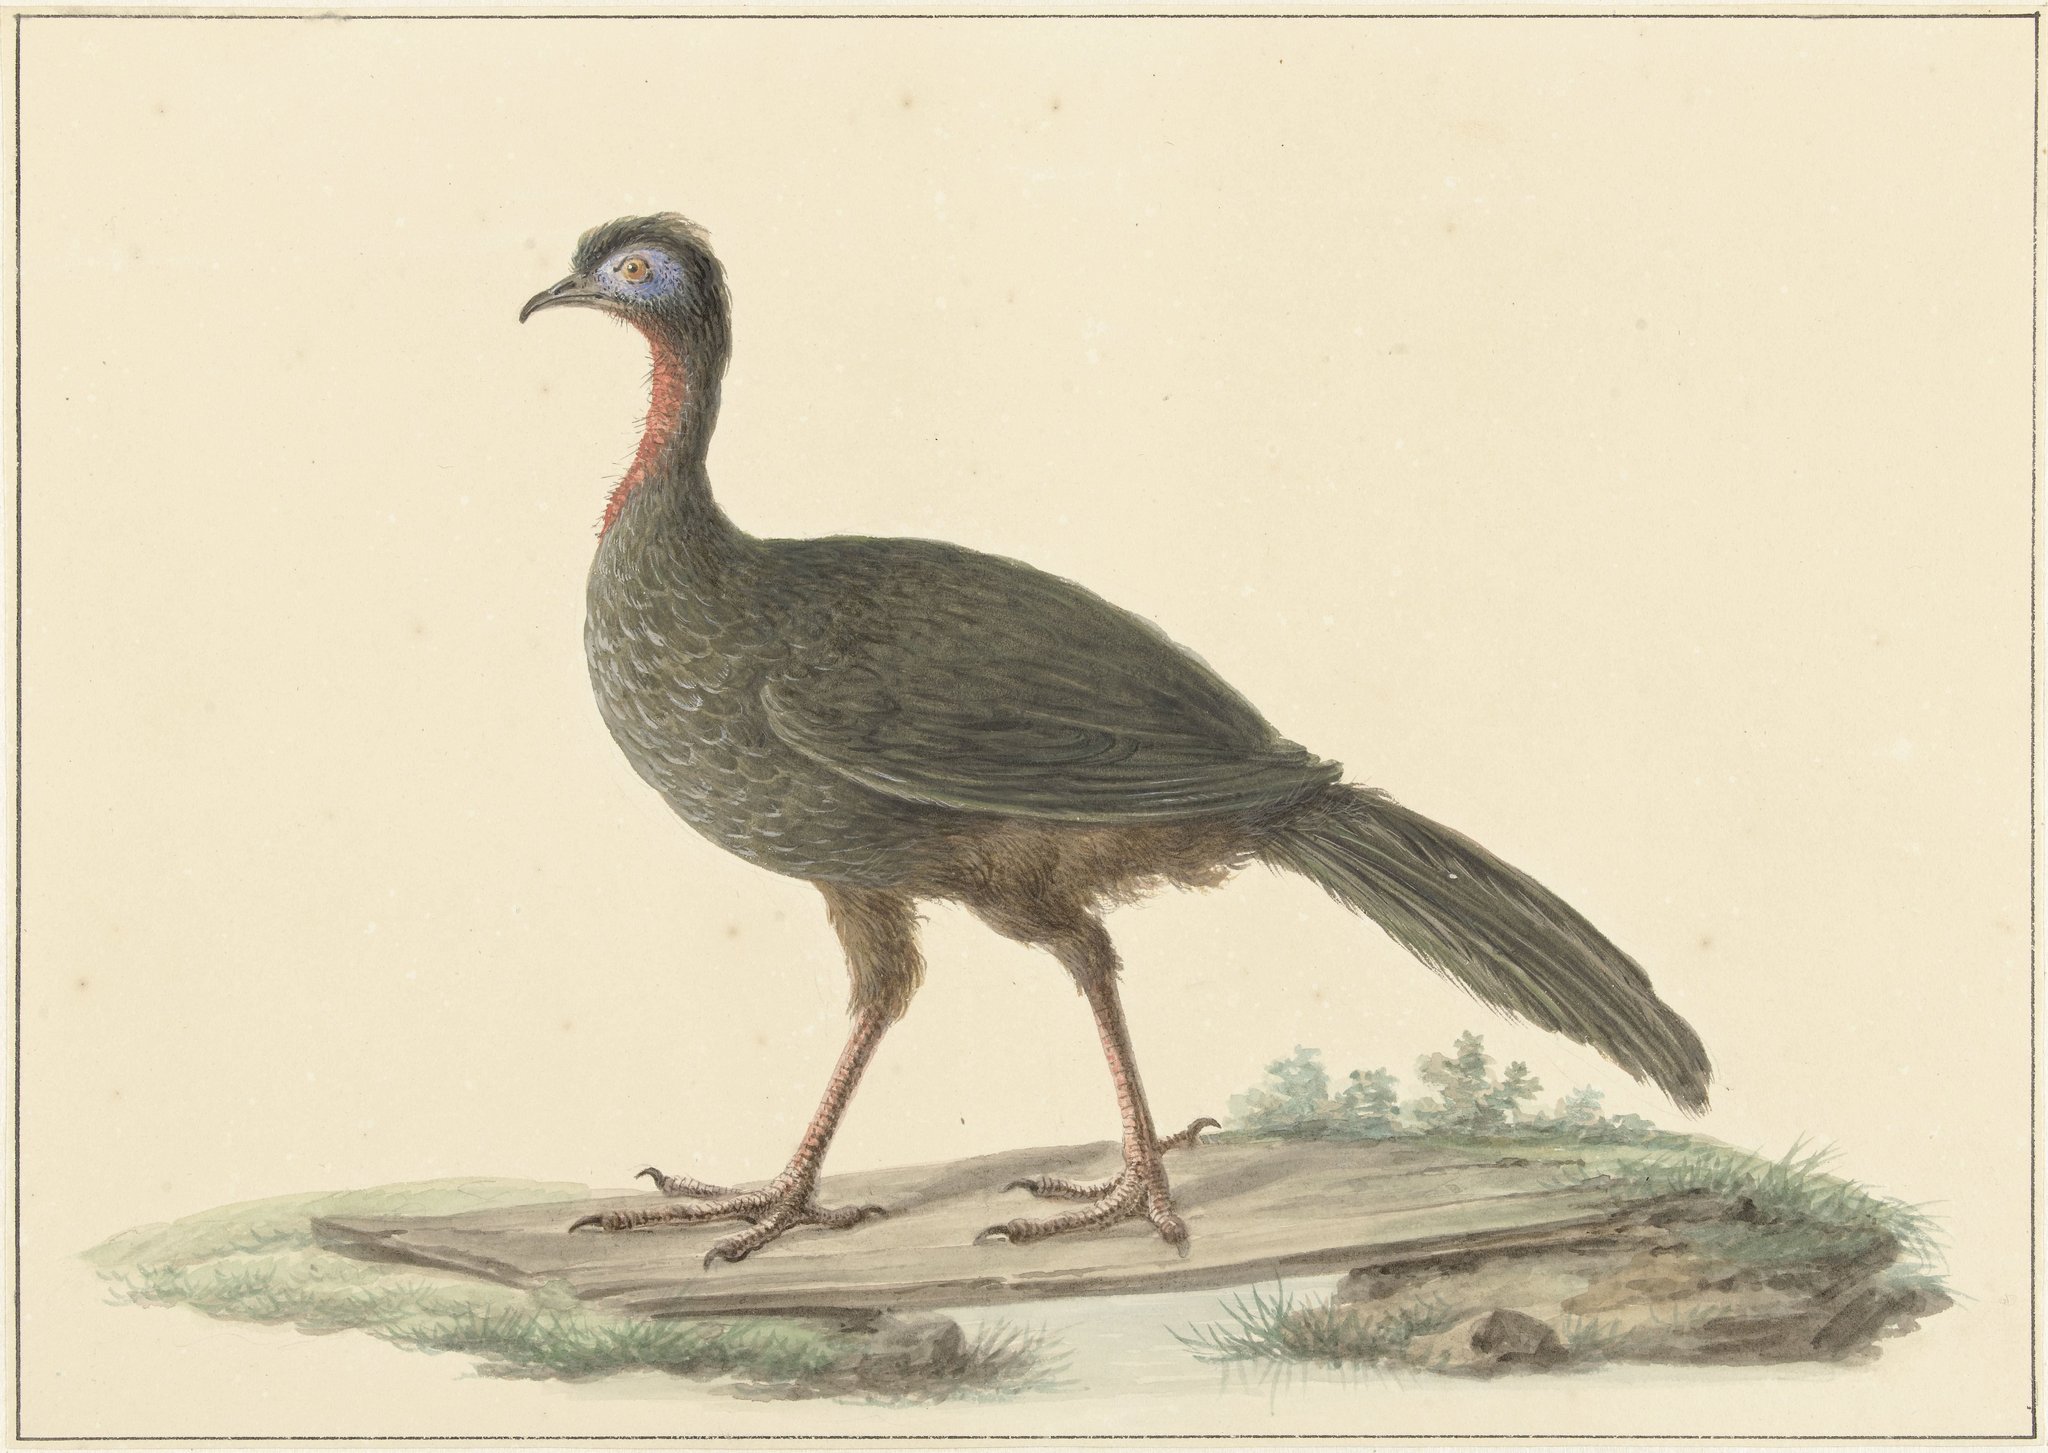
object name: watercolor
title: Marailsjakohoen (Penelope marail)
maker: pieter pietersz. barbiers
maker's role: draughtsman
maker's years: 1749-1842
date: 1759-1842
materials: paper, pencil, watercolor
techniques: brush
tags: walker and runner birds: marail guan